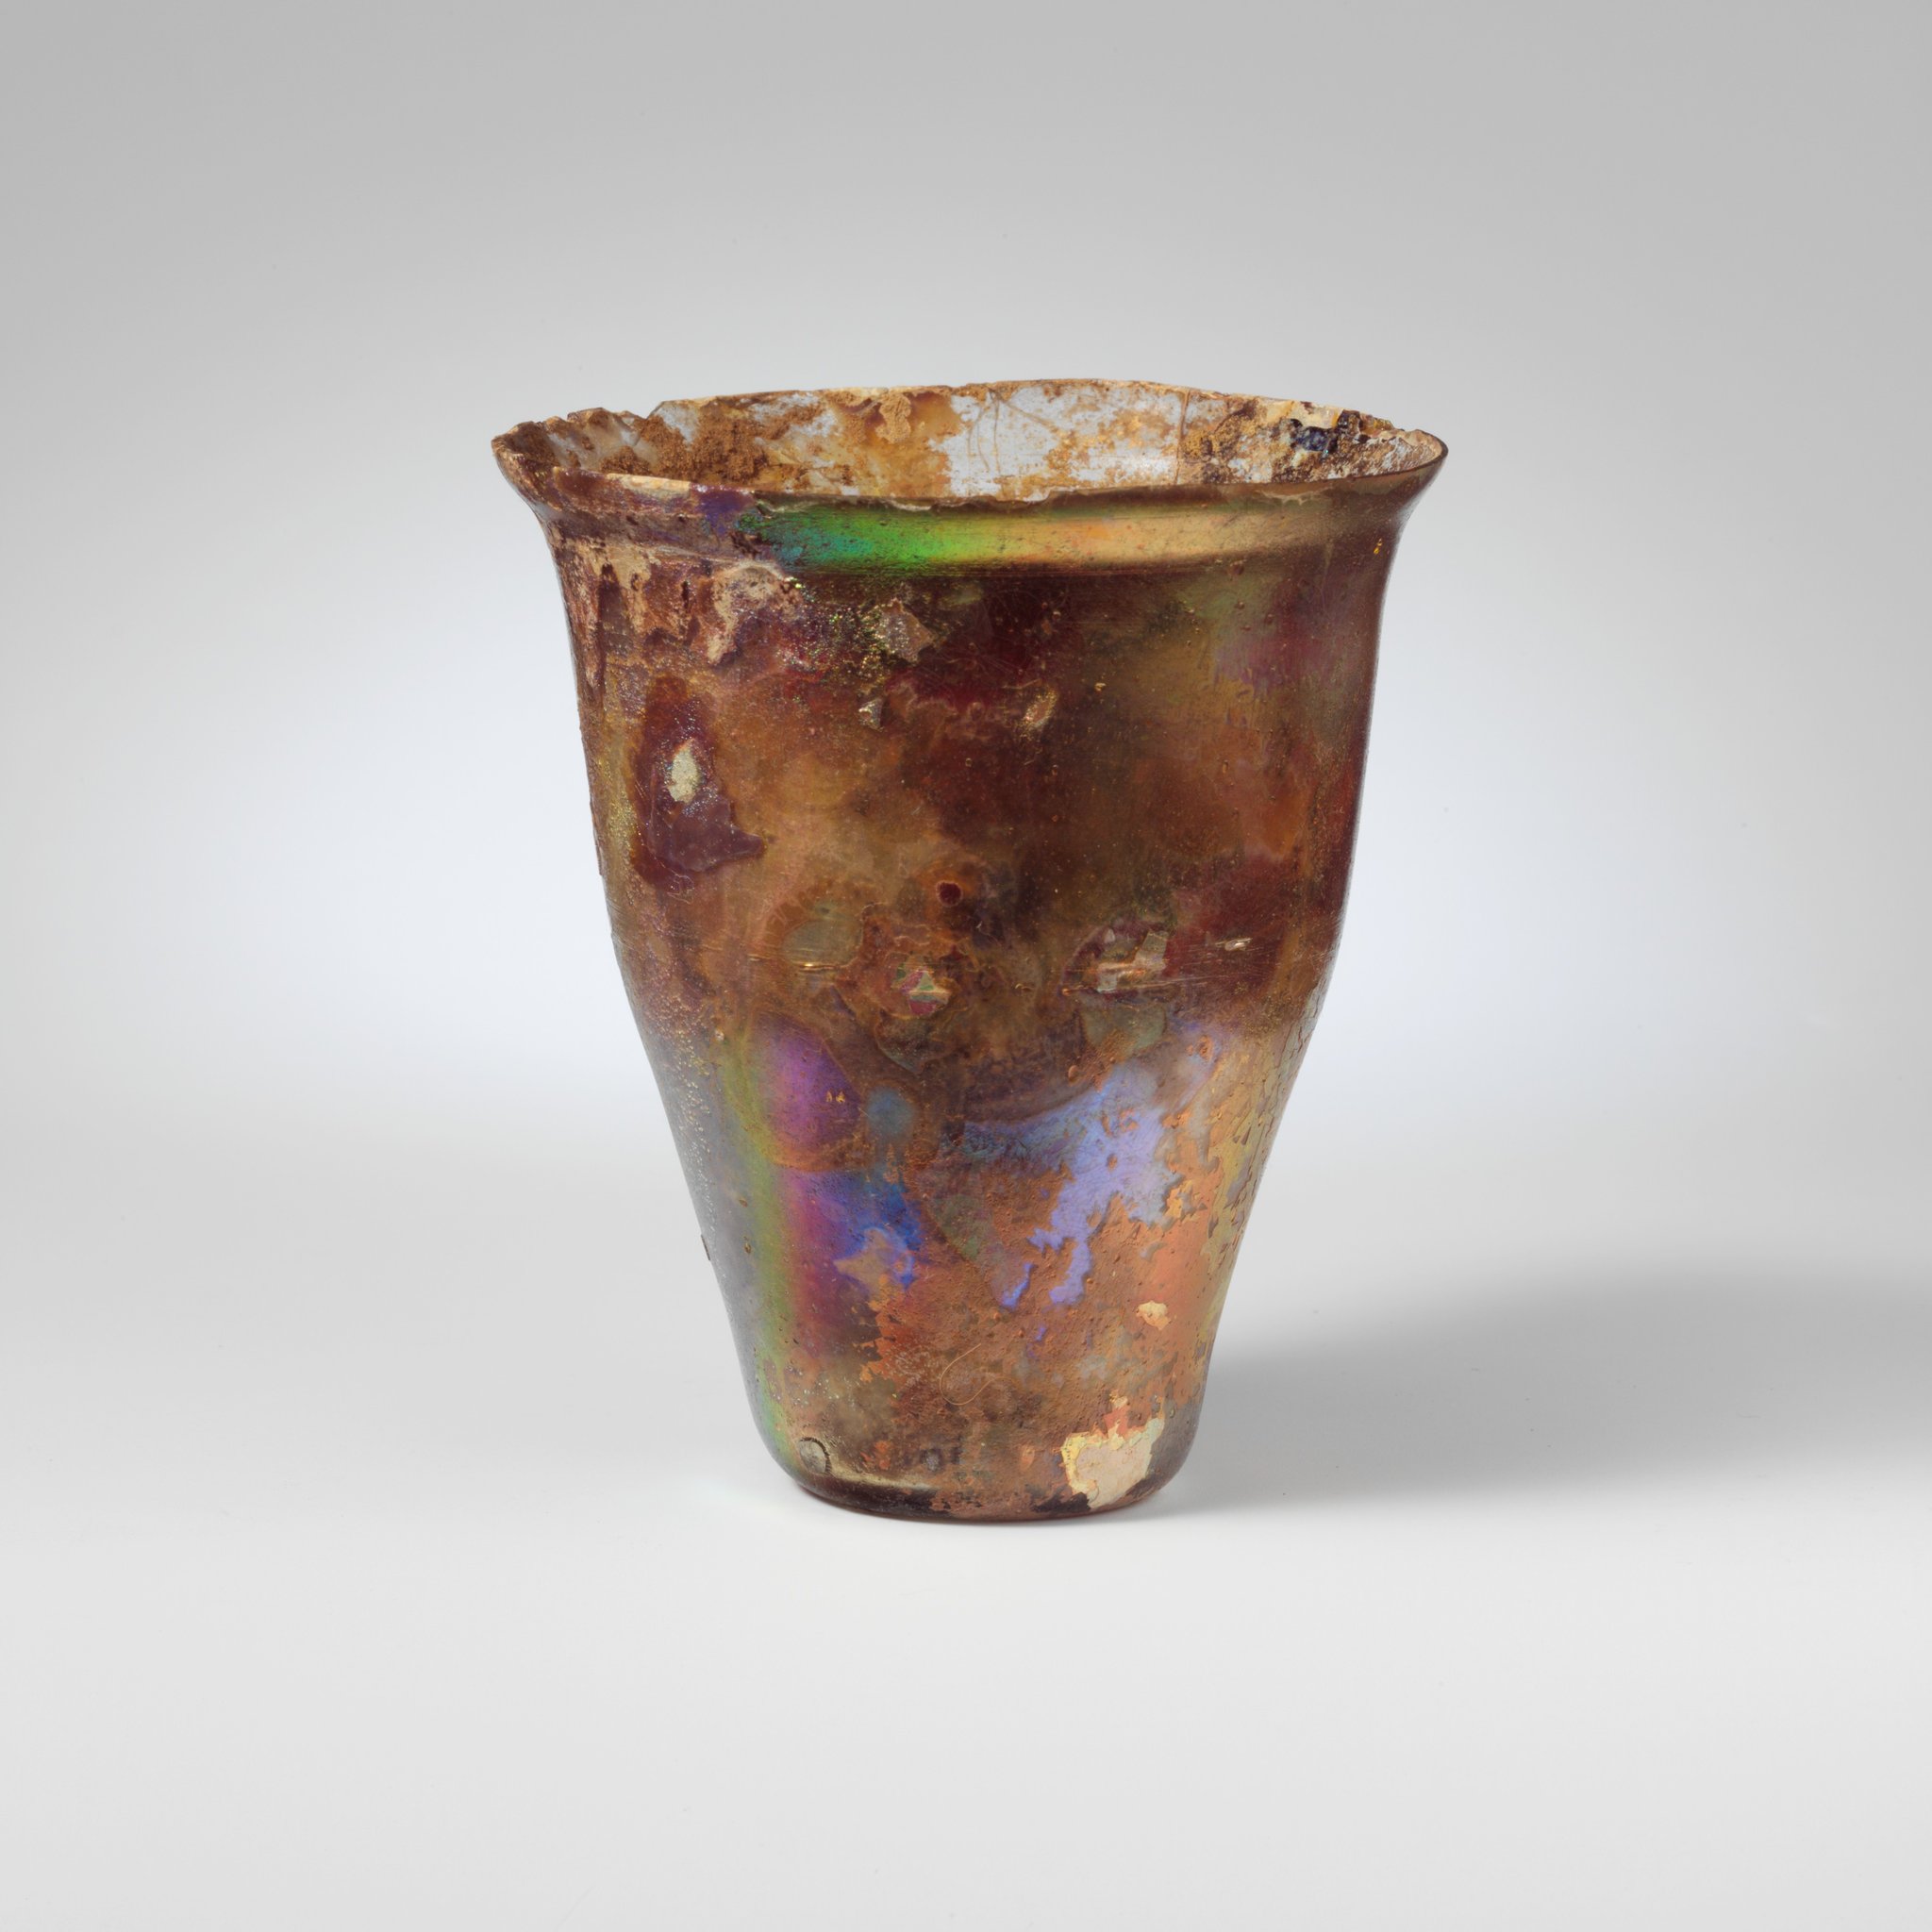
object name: beaker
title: Glass beaker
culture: roman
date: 1-100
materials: glass